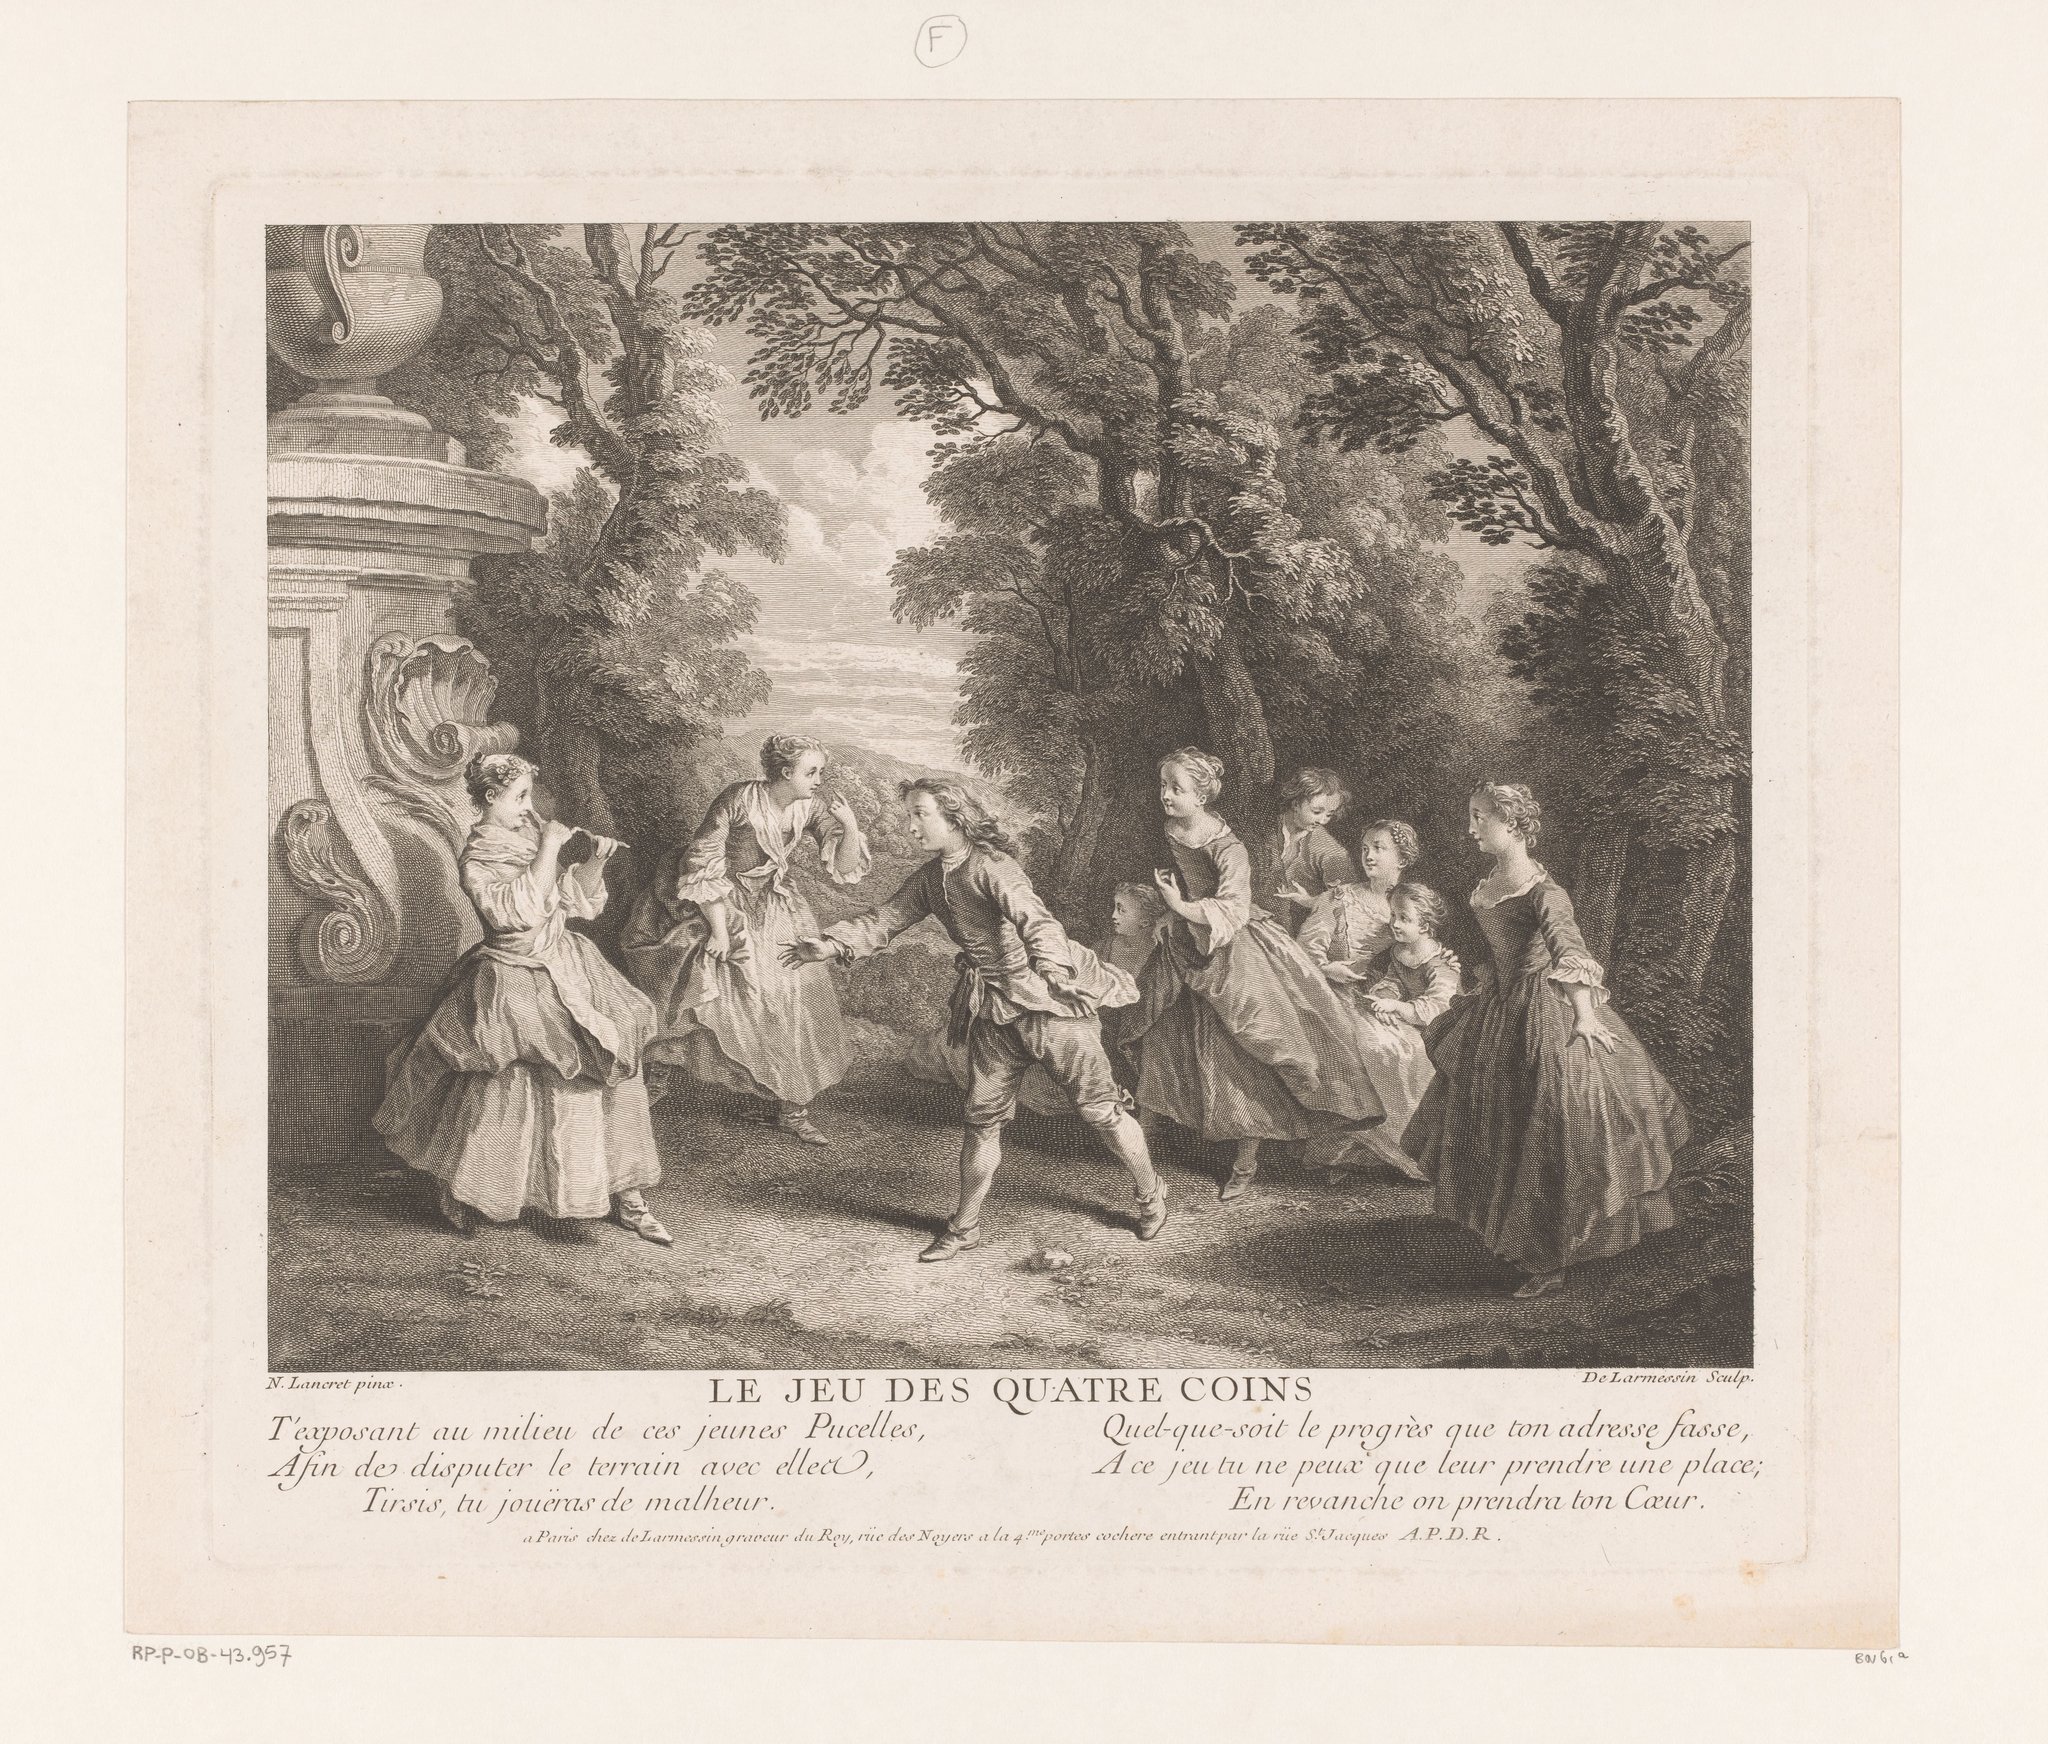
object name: print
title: Le Jeu des Quatre Coins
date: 1737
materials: paper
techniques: engraving, etching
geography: france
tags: games without play material, postures and gestures of thumb and other fingers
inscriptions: collector's mark: Lugt 2228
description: Elegant geklede kinderen spelen een spel in een cirkel, een jongen staat in het midden.